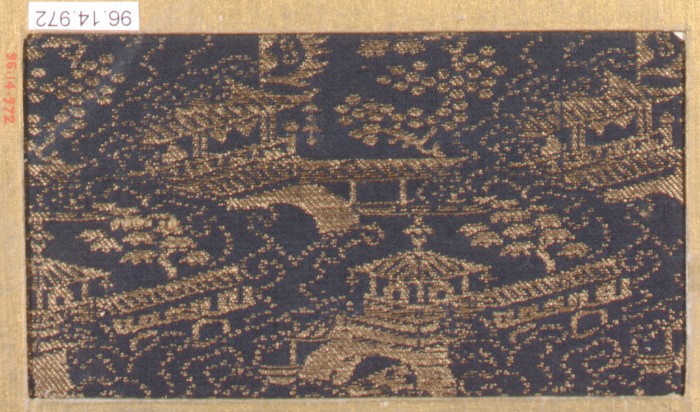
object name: piece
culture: japanese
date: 1701-1900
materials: silk